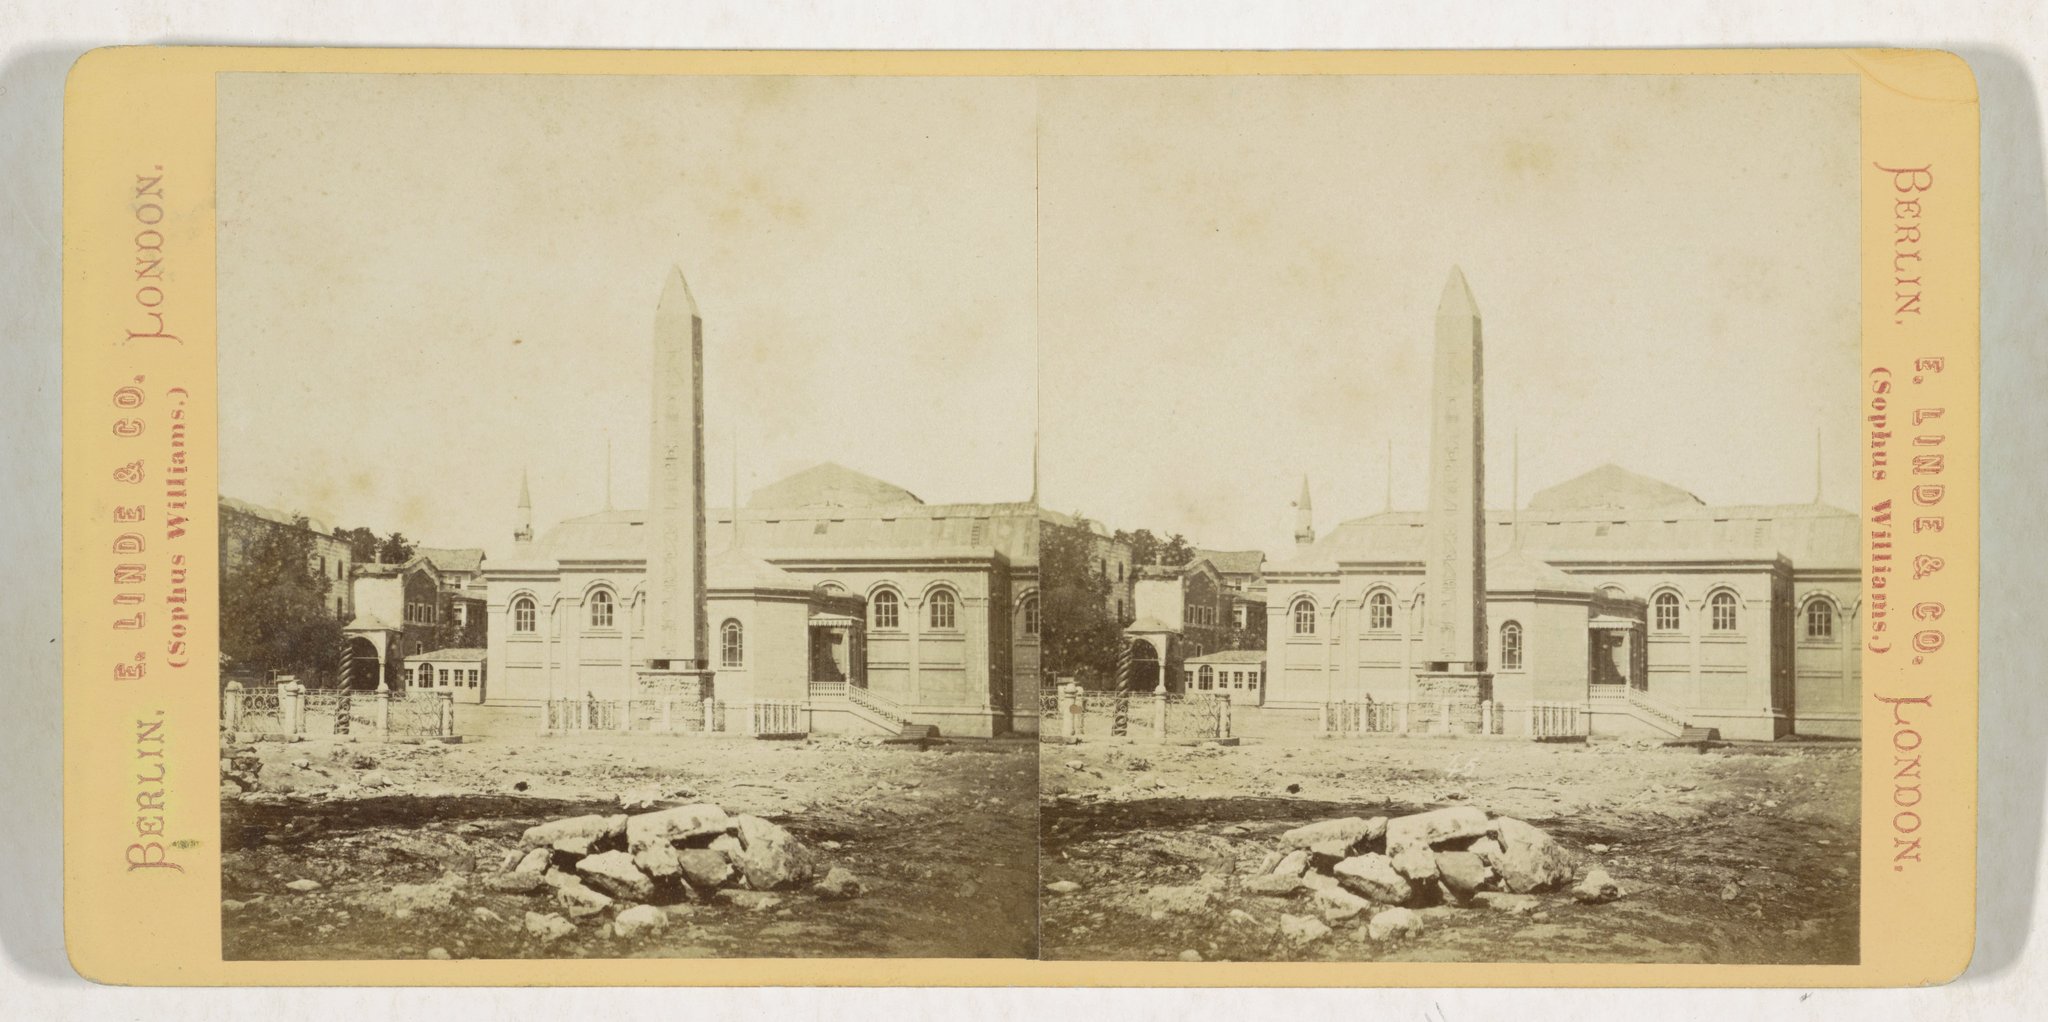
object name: stereograph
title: Obelisk van Theodosius in Istanboel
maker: Anonymous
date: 1873-1890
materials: cardboard, paper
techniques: albumen print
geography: obelisk van theodosius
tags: obelisk van theodosius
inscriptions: number: ‘45’